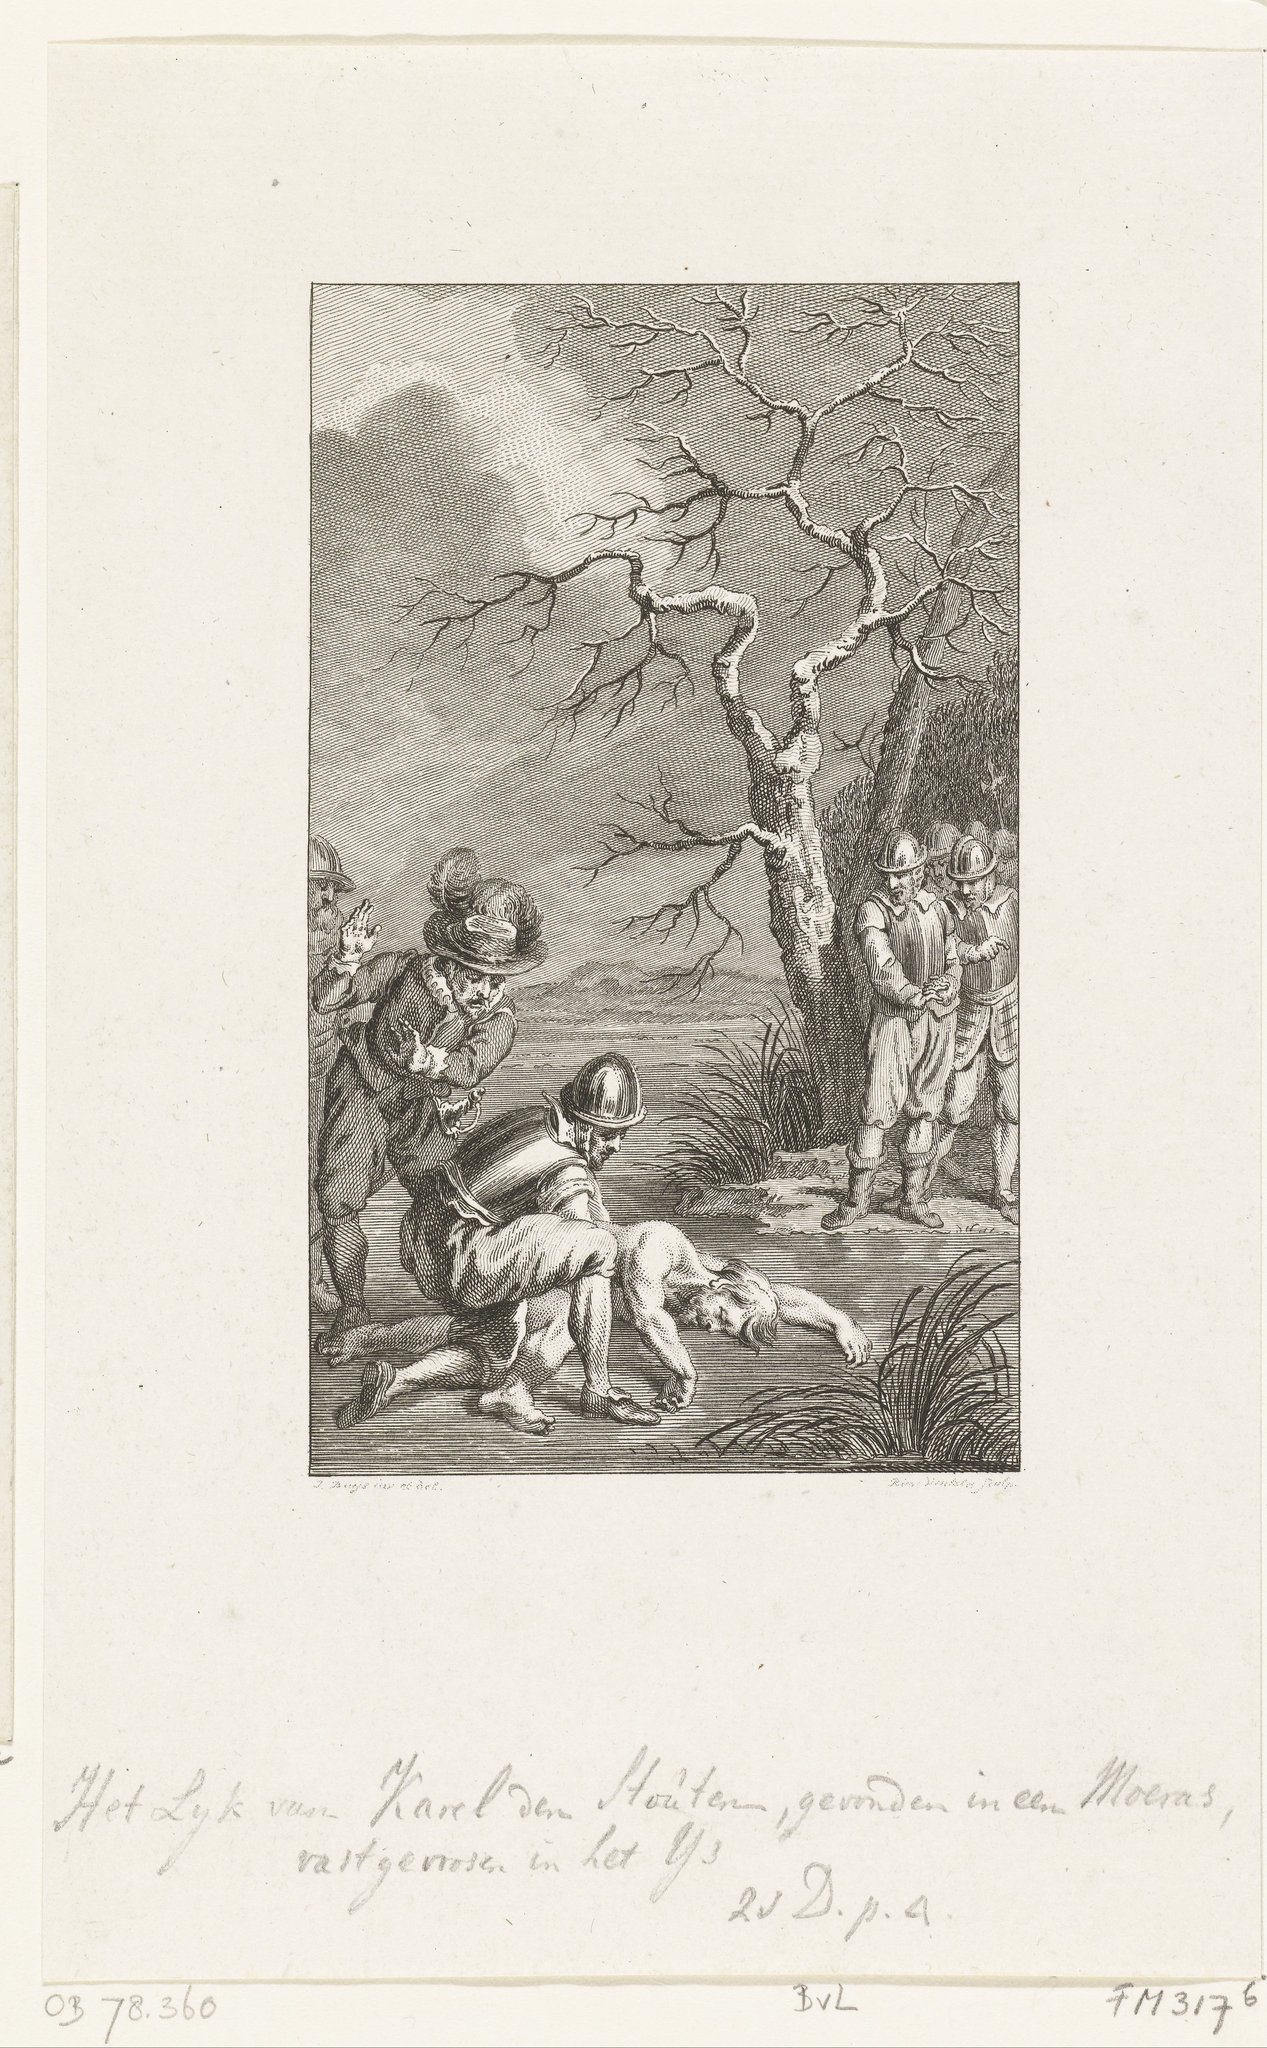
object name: history print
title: Het lijk van Karel de Stoute, gevonden in een moeras, vastgevroren in het ijs, 1477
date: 1789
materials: paper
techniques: etching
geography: netherlands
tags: earl, charles the bold (duke of burgundy), violent death, being killed; being mishandled and maltreated; seeking death (+ finding of dead or dying person), burgundian netherlands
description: Illustratie voor: Jacobus Kok, Vaderlandsch Woordenboek, Johannes Allart, Amsterdam 1785-1799, 35 delen, dl. XXI, pl. IV. Staat vóór de letter.